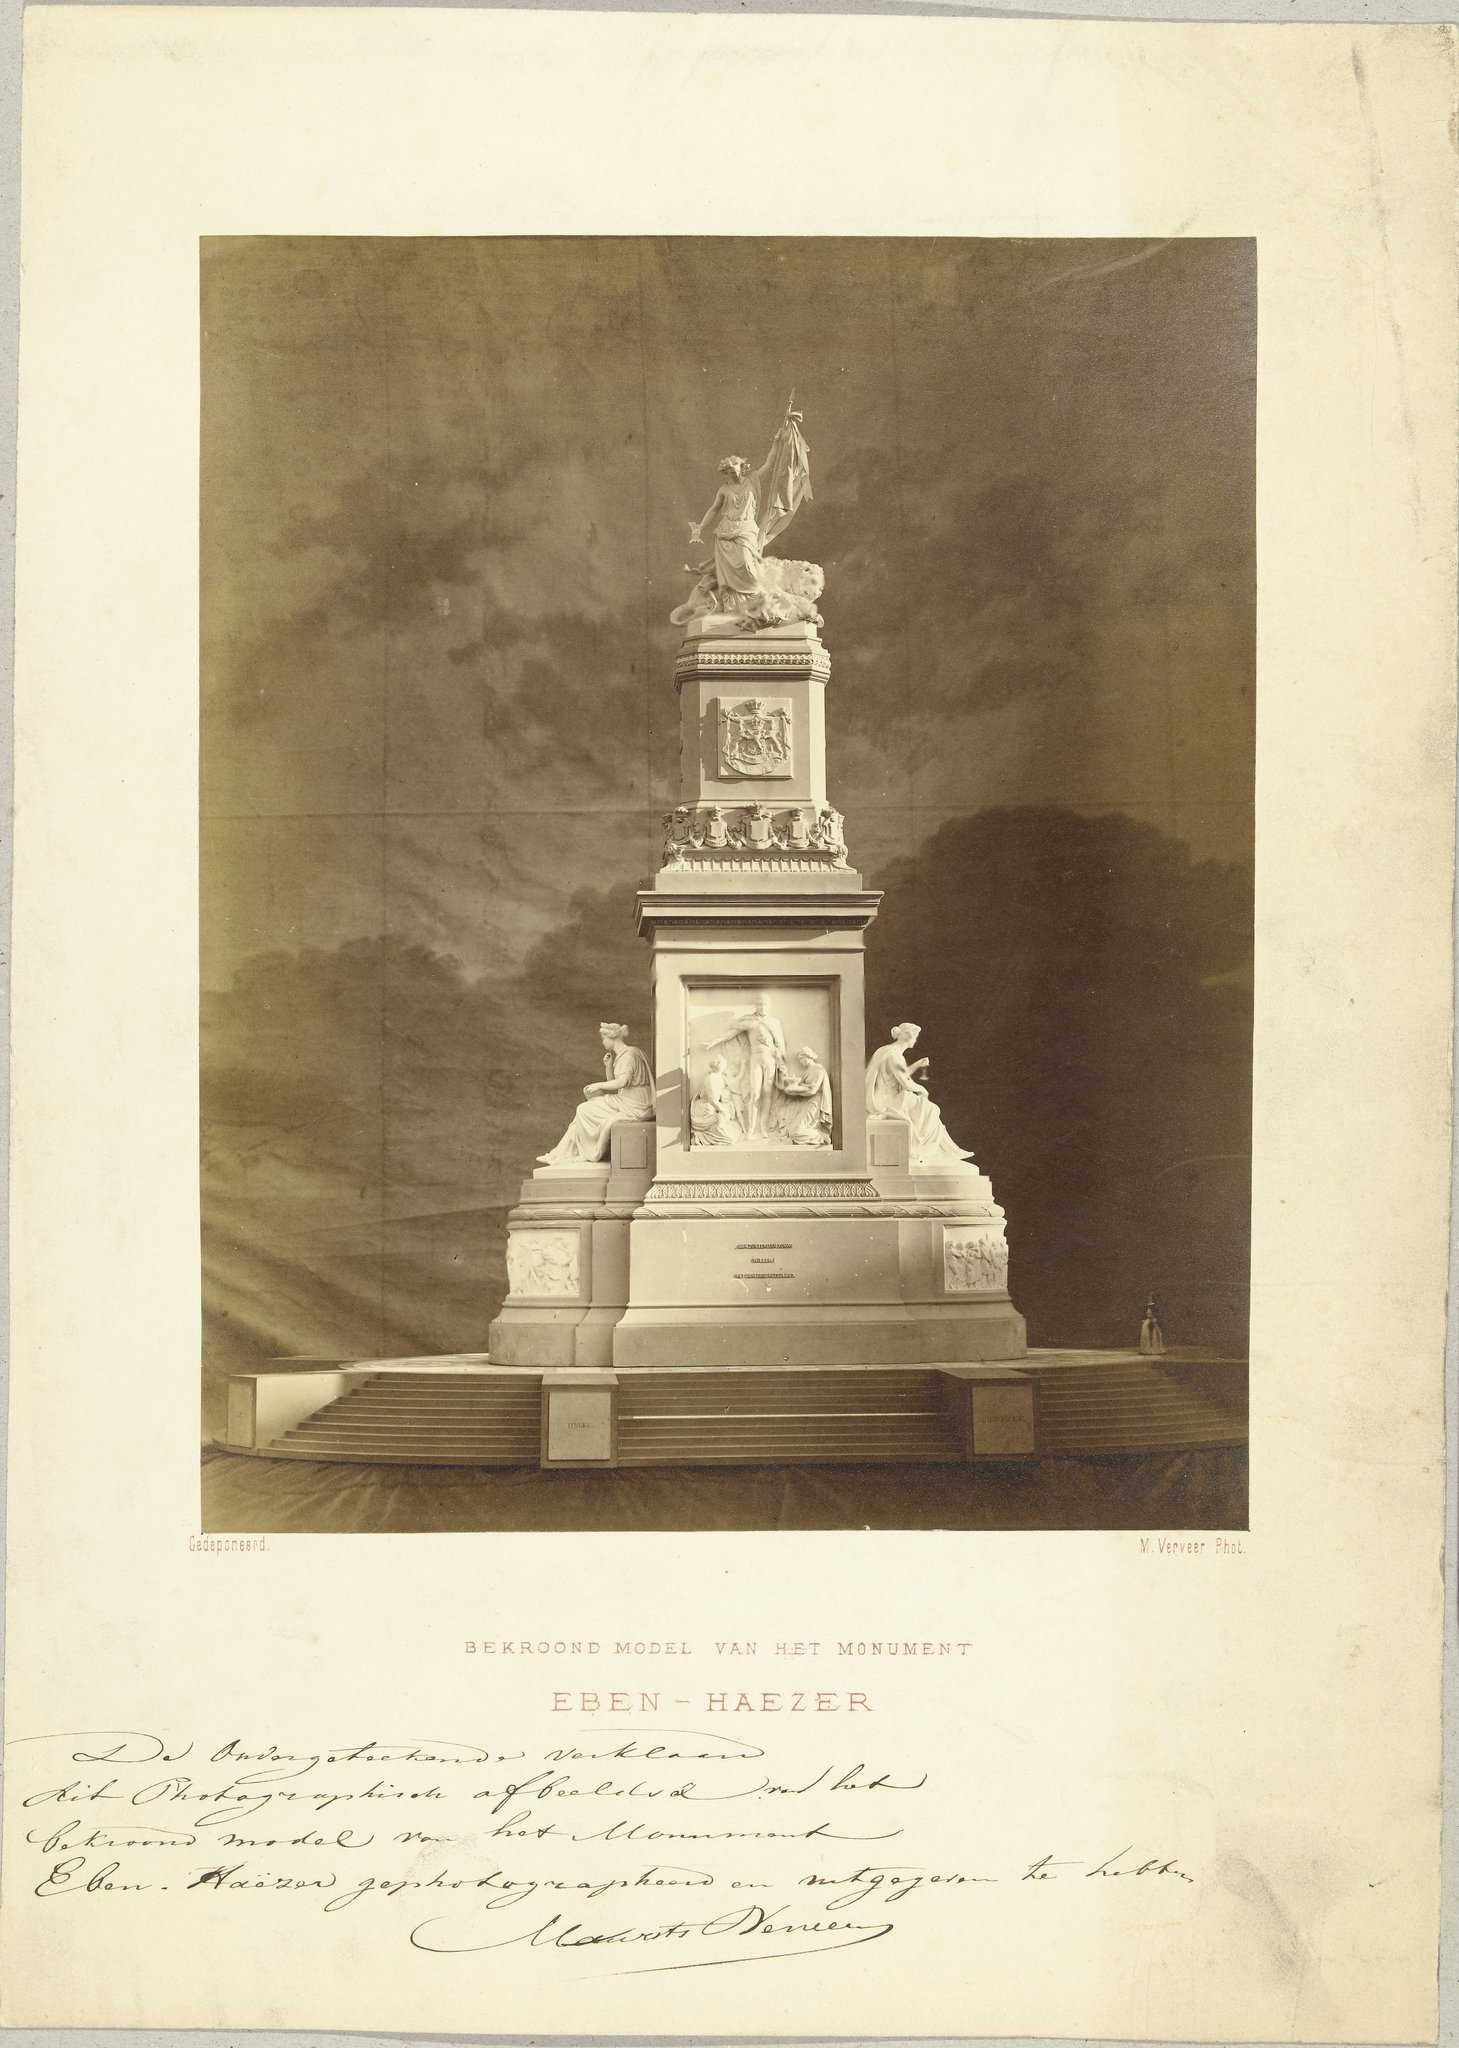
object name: photograph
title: Bekroond model van het monument Eben-Haezer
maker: maurits verveer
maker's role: painter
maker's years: 1817-1903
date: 1864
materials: cardboard, paper, photographic support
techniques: albumen print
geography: the hague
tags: sculpture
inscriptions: annotation: ‘De ondergetekende verklaard dit photographisch afbeeldsel van het bekroonde monument Eben-Haezer gephotografeerd e nuitgegeven te hebben M. Verveer’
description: Fragment van het bekroond ontwerp voor het Nationaal Monument 1813-1863 [motto Eben-Haezer] in Den Haag, van J.Ph. Koelman en W.C. van der Waeyen Pieterse